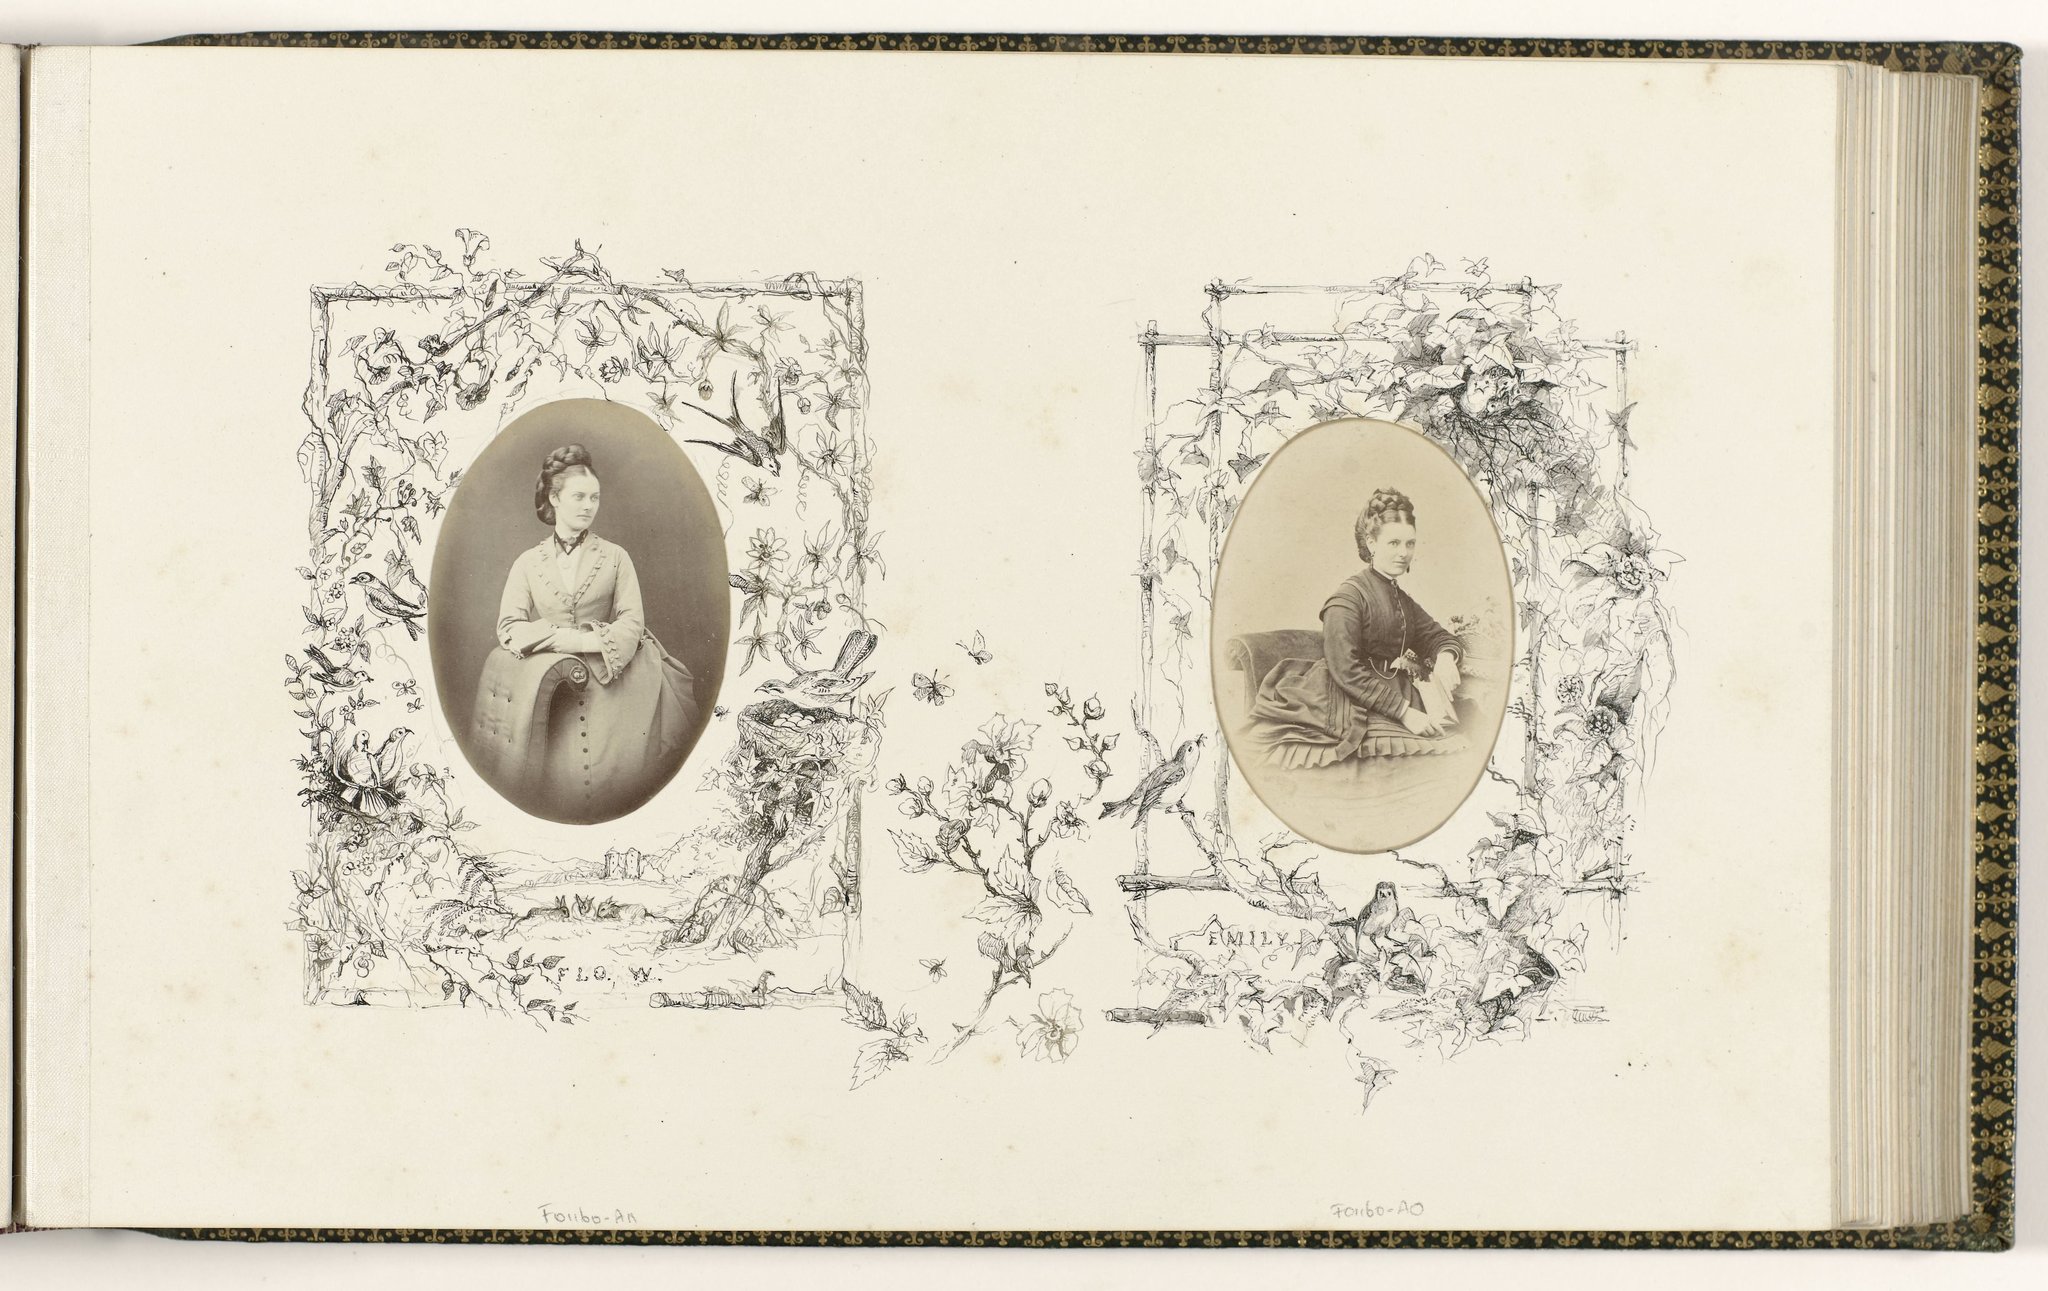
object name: album leaf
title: Portret van een onbekende vrouw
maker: Anonymous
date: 1865-1875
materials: paper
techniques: albumen print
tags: historical persons - bb - woman